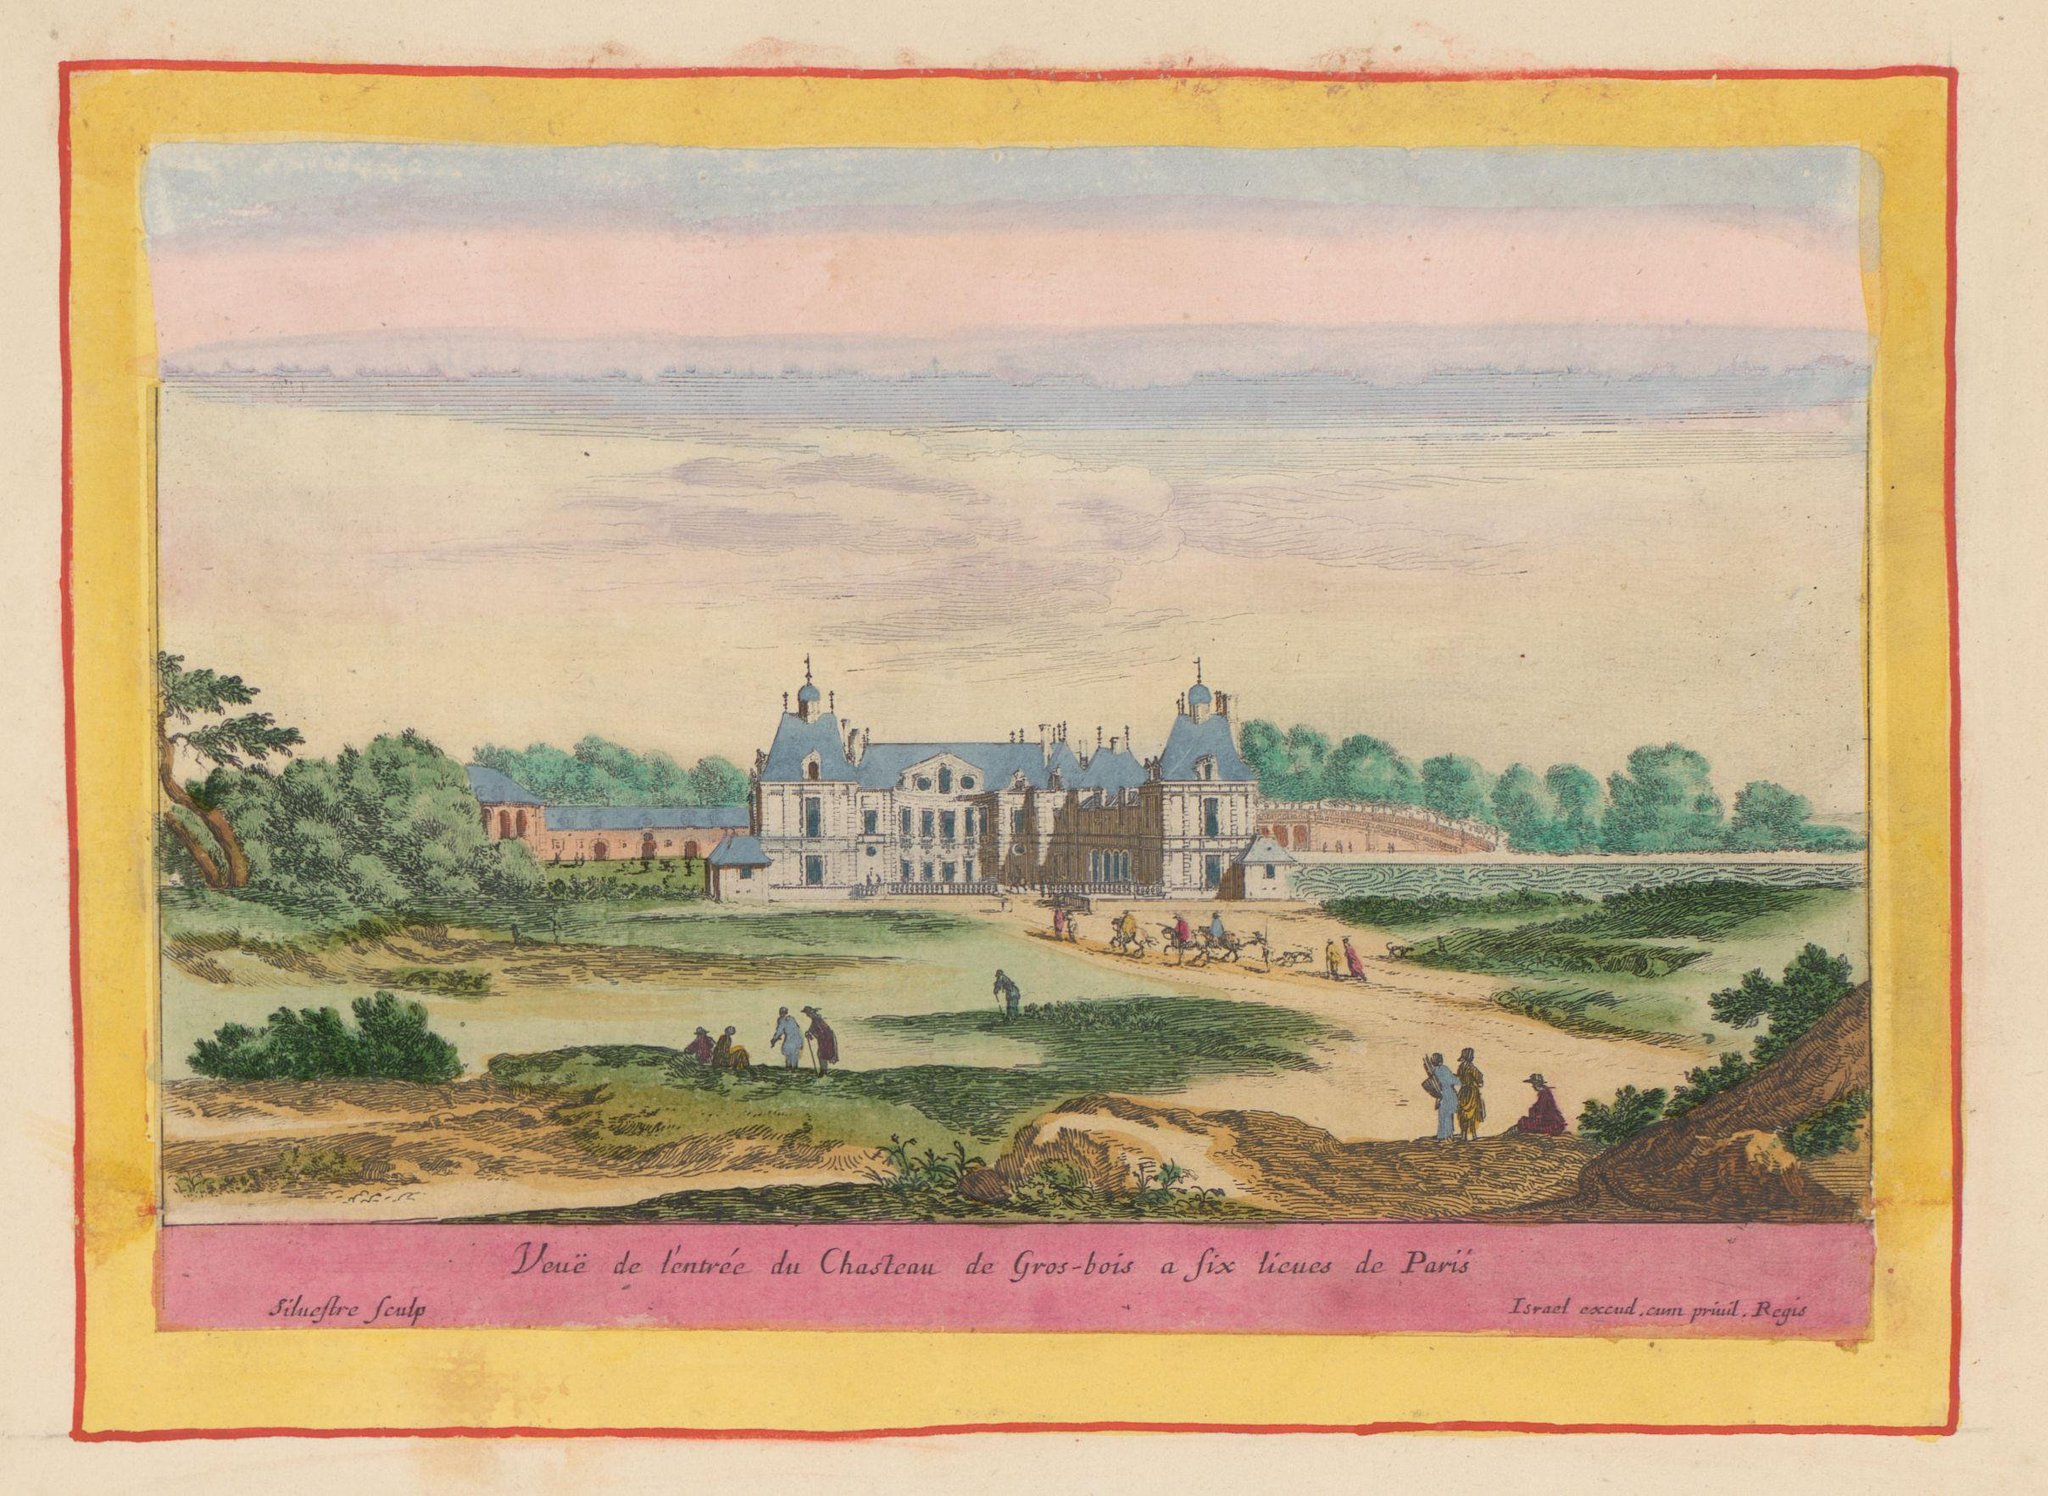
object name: print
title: Veuë de l'entrée du Chasteau de Gros-bois a six lieues de Paris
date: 1631-1691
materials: paper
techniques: etching, hand coloring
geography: paris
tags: castle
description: De voorstelling is aan de bovenzijde aangevuld met een geschilderde lucht.